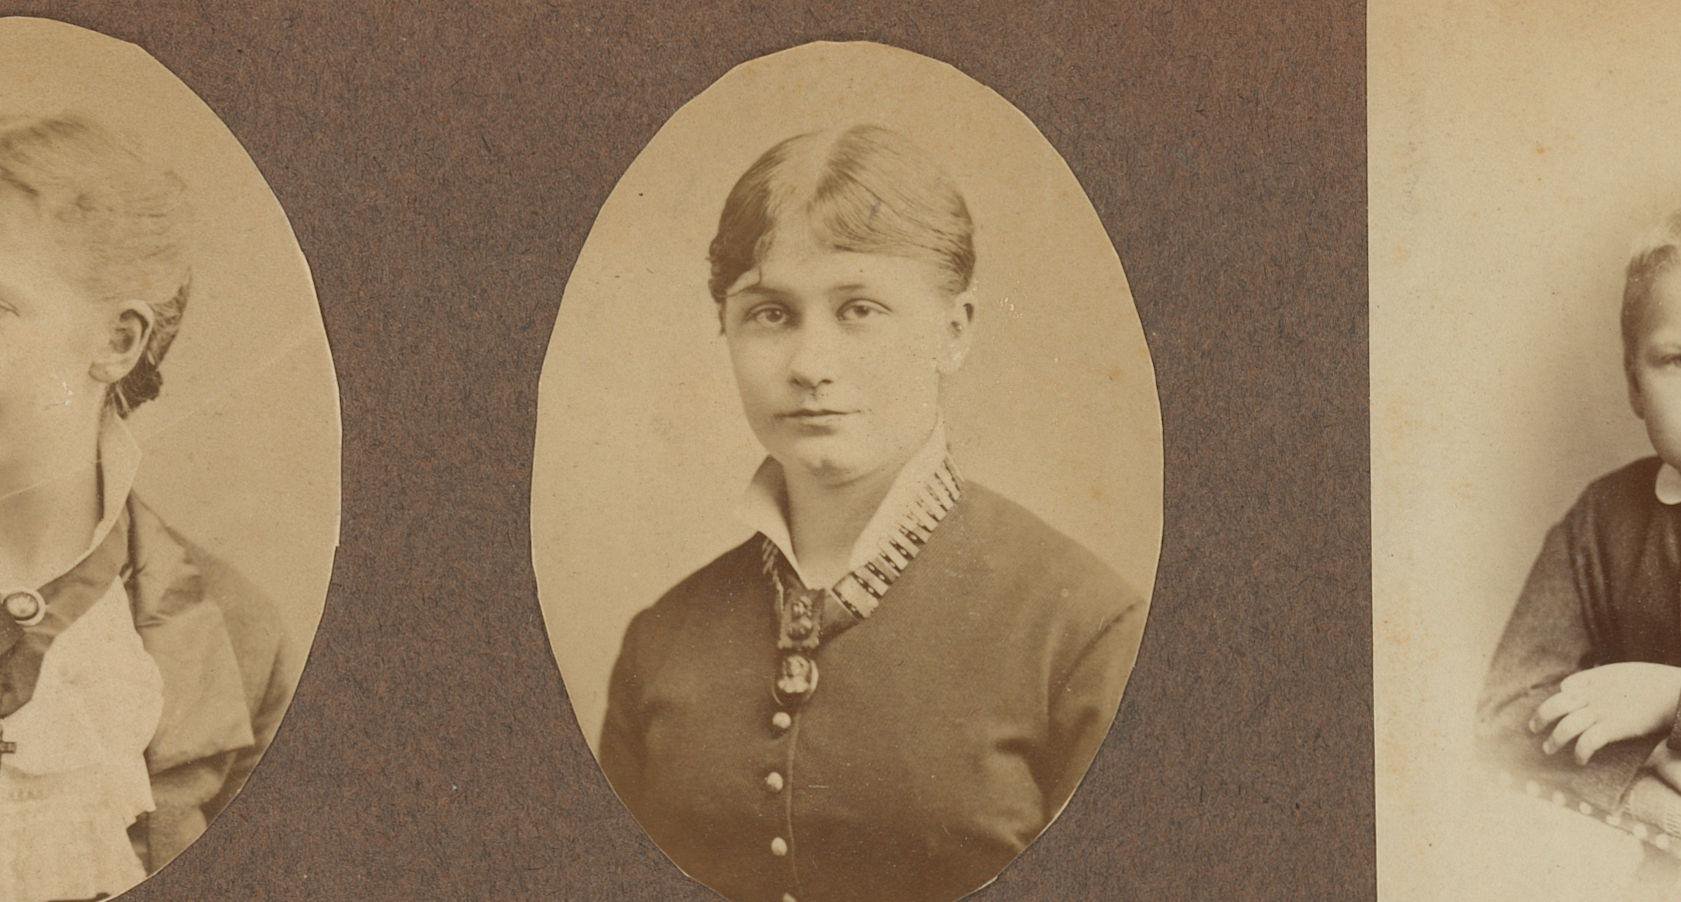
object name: photograph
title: Portret van jonge vrouw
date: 1877-1884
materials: photographic support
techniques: photography, snipping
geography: amsterdam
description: Foto op bruin albumblad 16 van familiealbum van Alphons Diepenbrock.